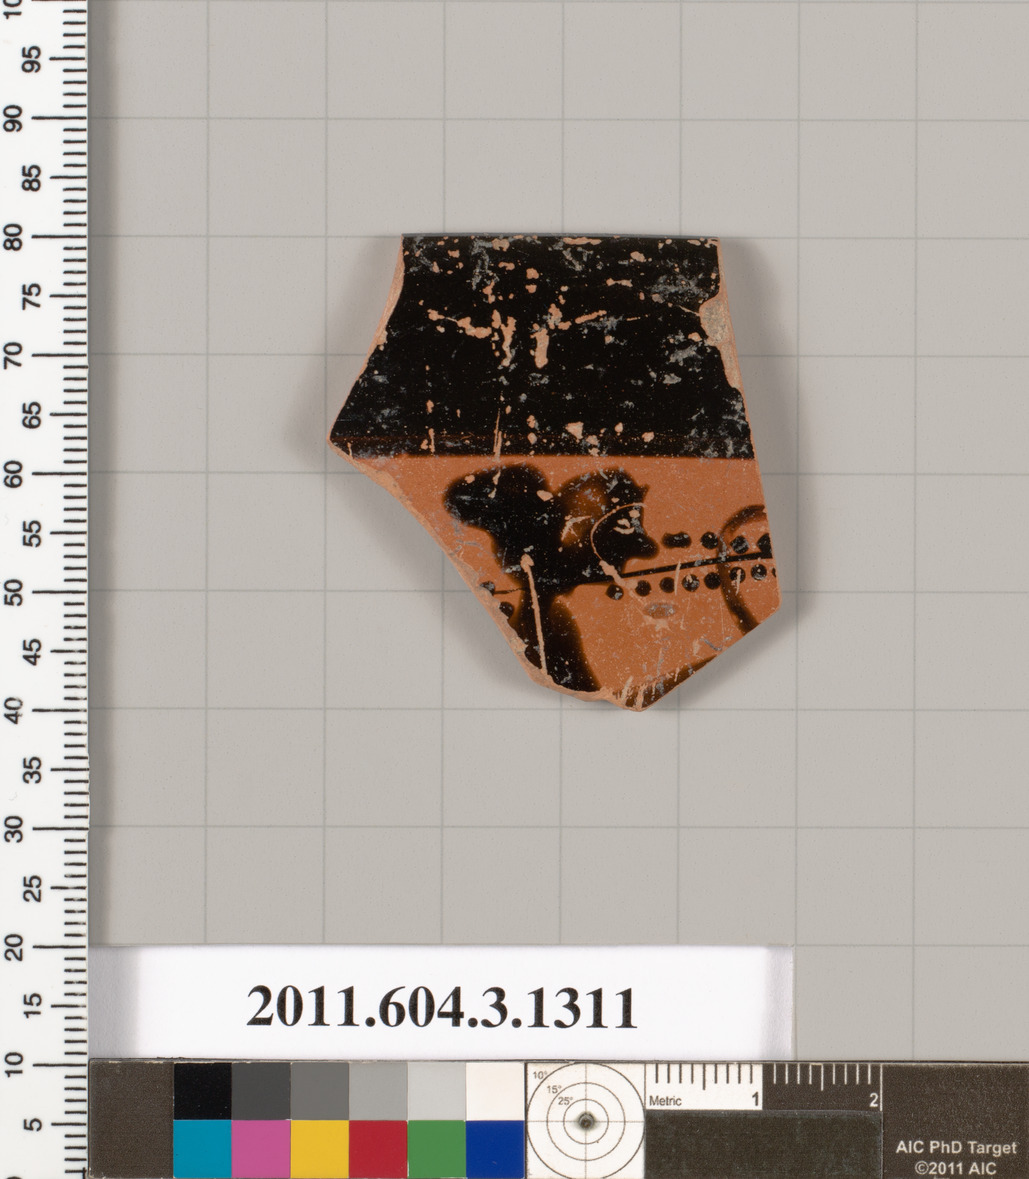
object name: skyphos fragment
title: Terracotta rim fragment of a skyphos (deep drinking cup)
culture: greek, attic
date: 490-480 BCE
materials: terracotta